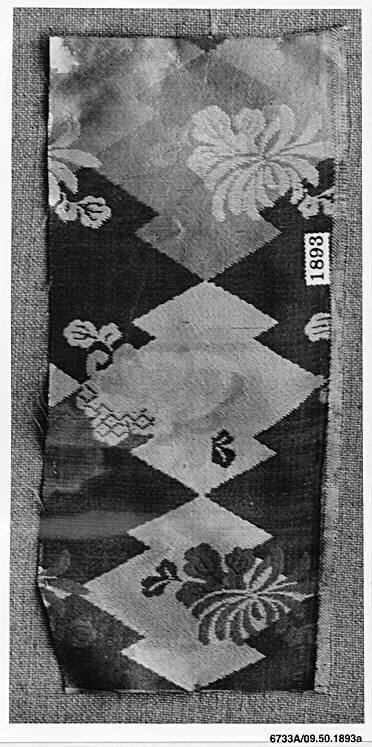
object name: fragment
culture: japanese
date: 1701-1800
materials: silk